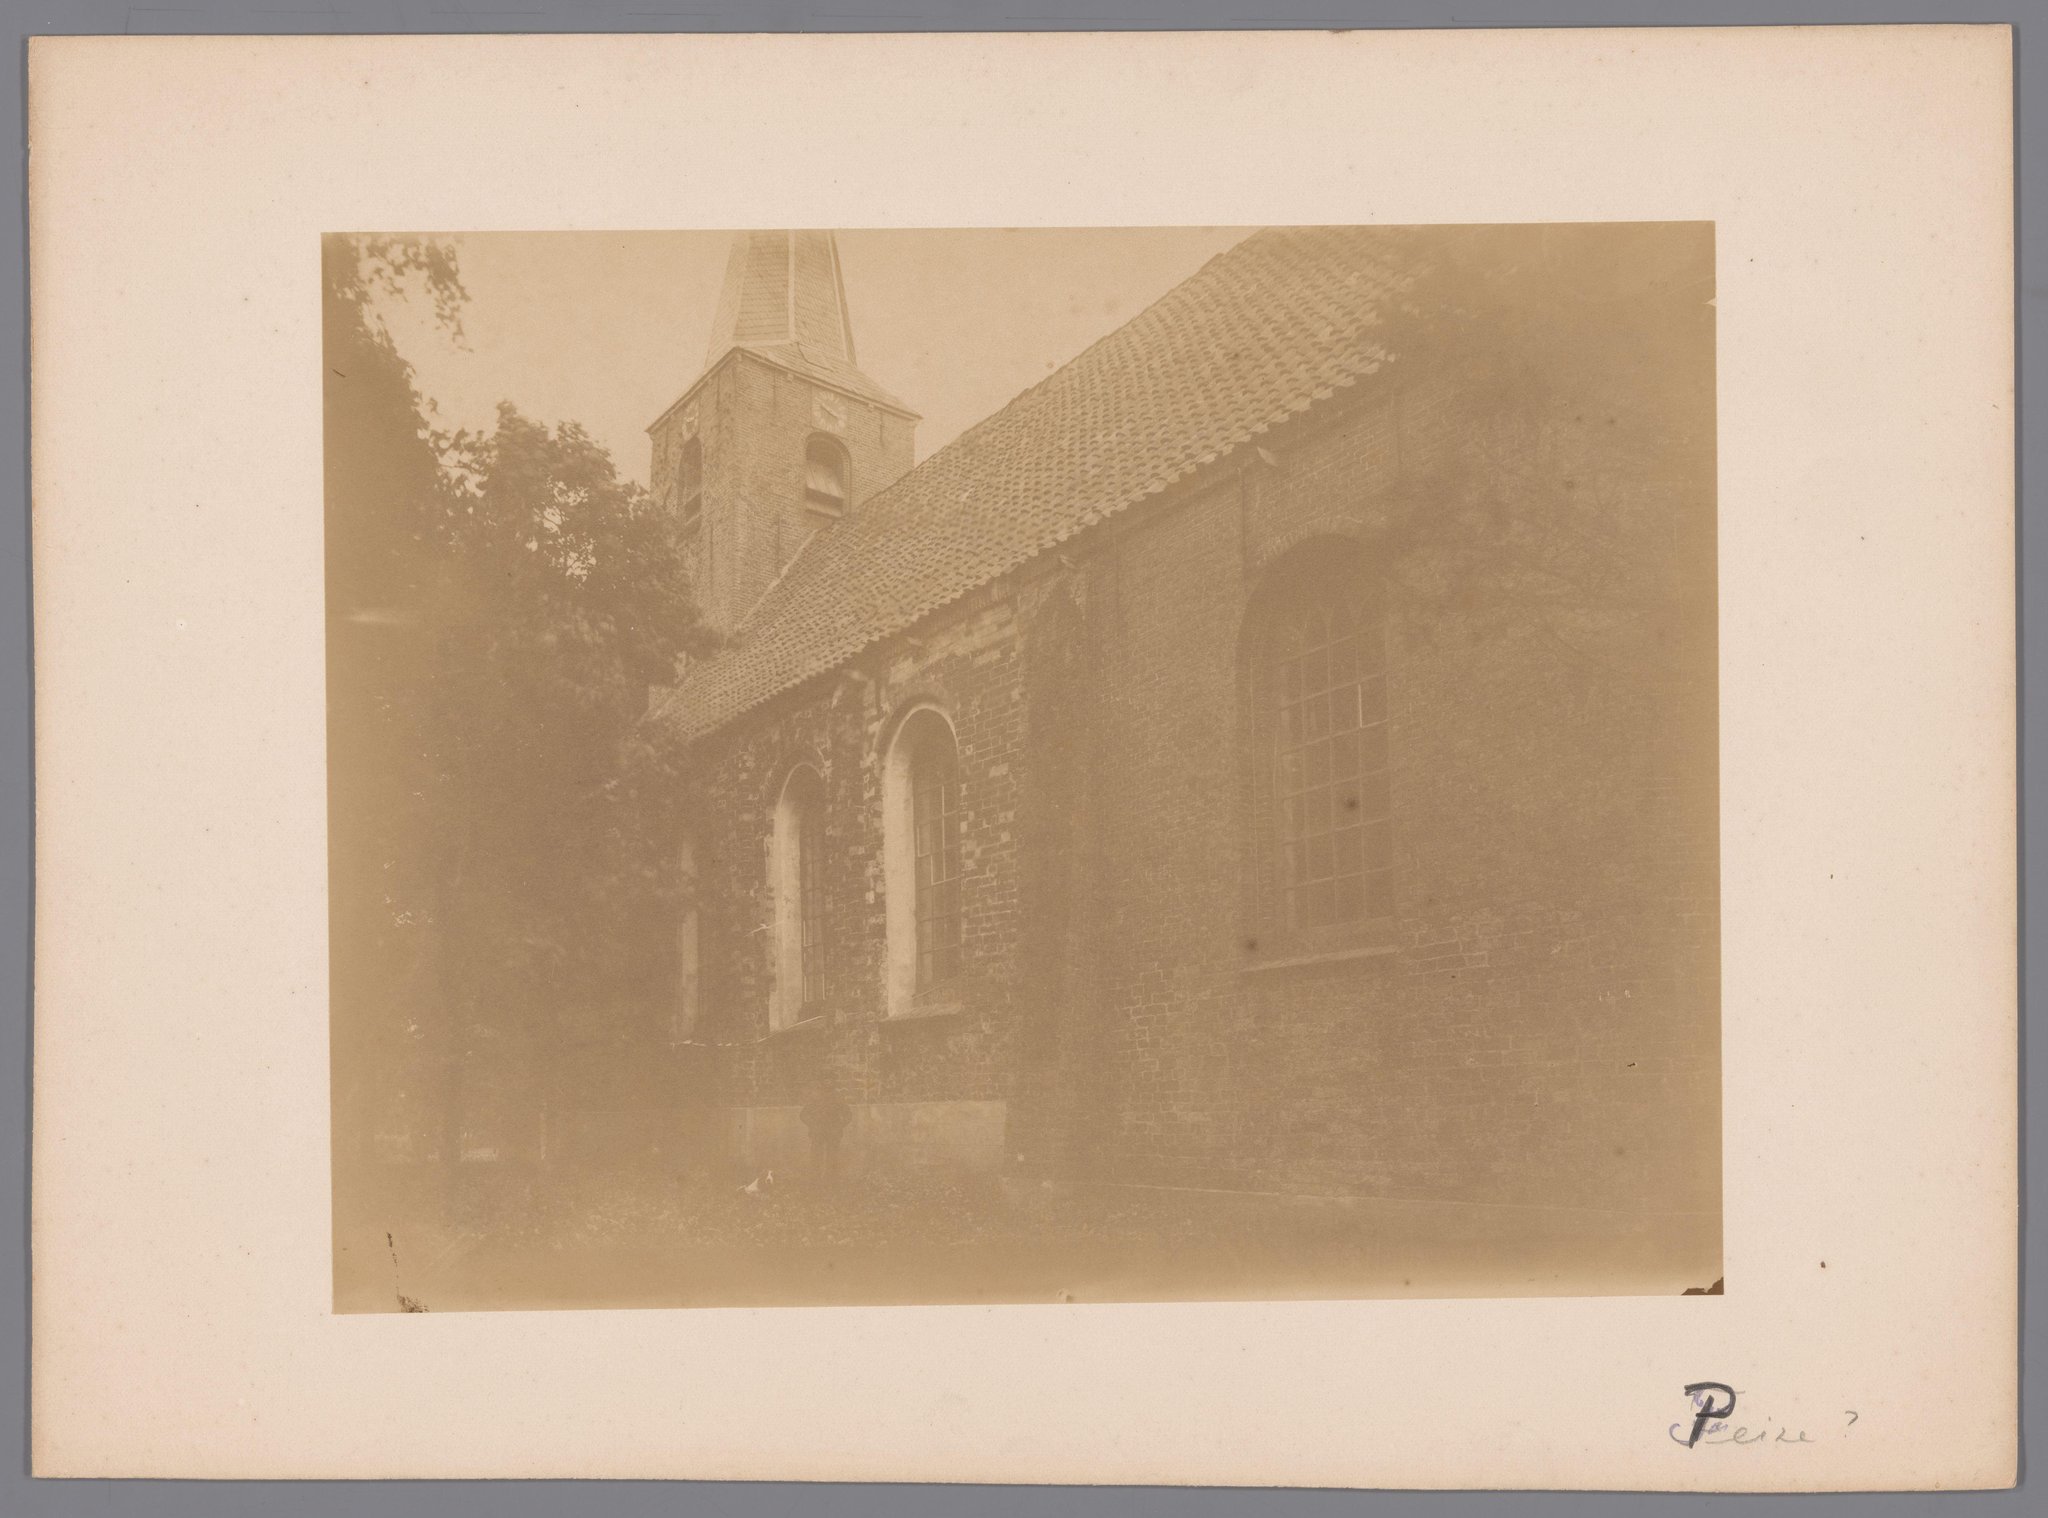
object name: photograph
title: Gezicht op de Hervormde Kerk te Peize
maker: anoniem (monumentenzorg)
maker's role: fotograaf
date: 1898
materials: cardboard, photographic support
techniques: albumen print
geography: peize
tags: church (exterior)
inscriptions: annotation: ‘Kerk v/d N.H. gemeente te Peize (?)/ (Drenthe)/ Aug 1898’, annotation: ‘Peize’